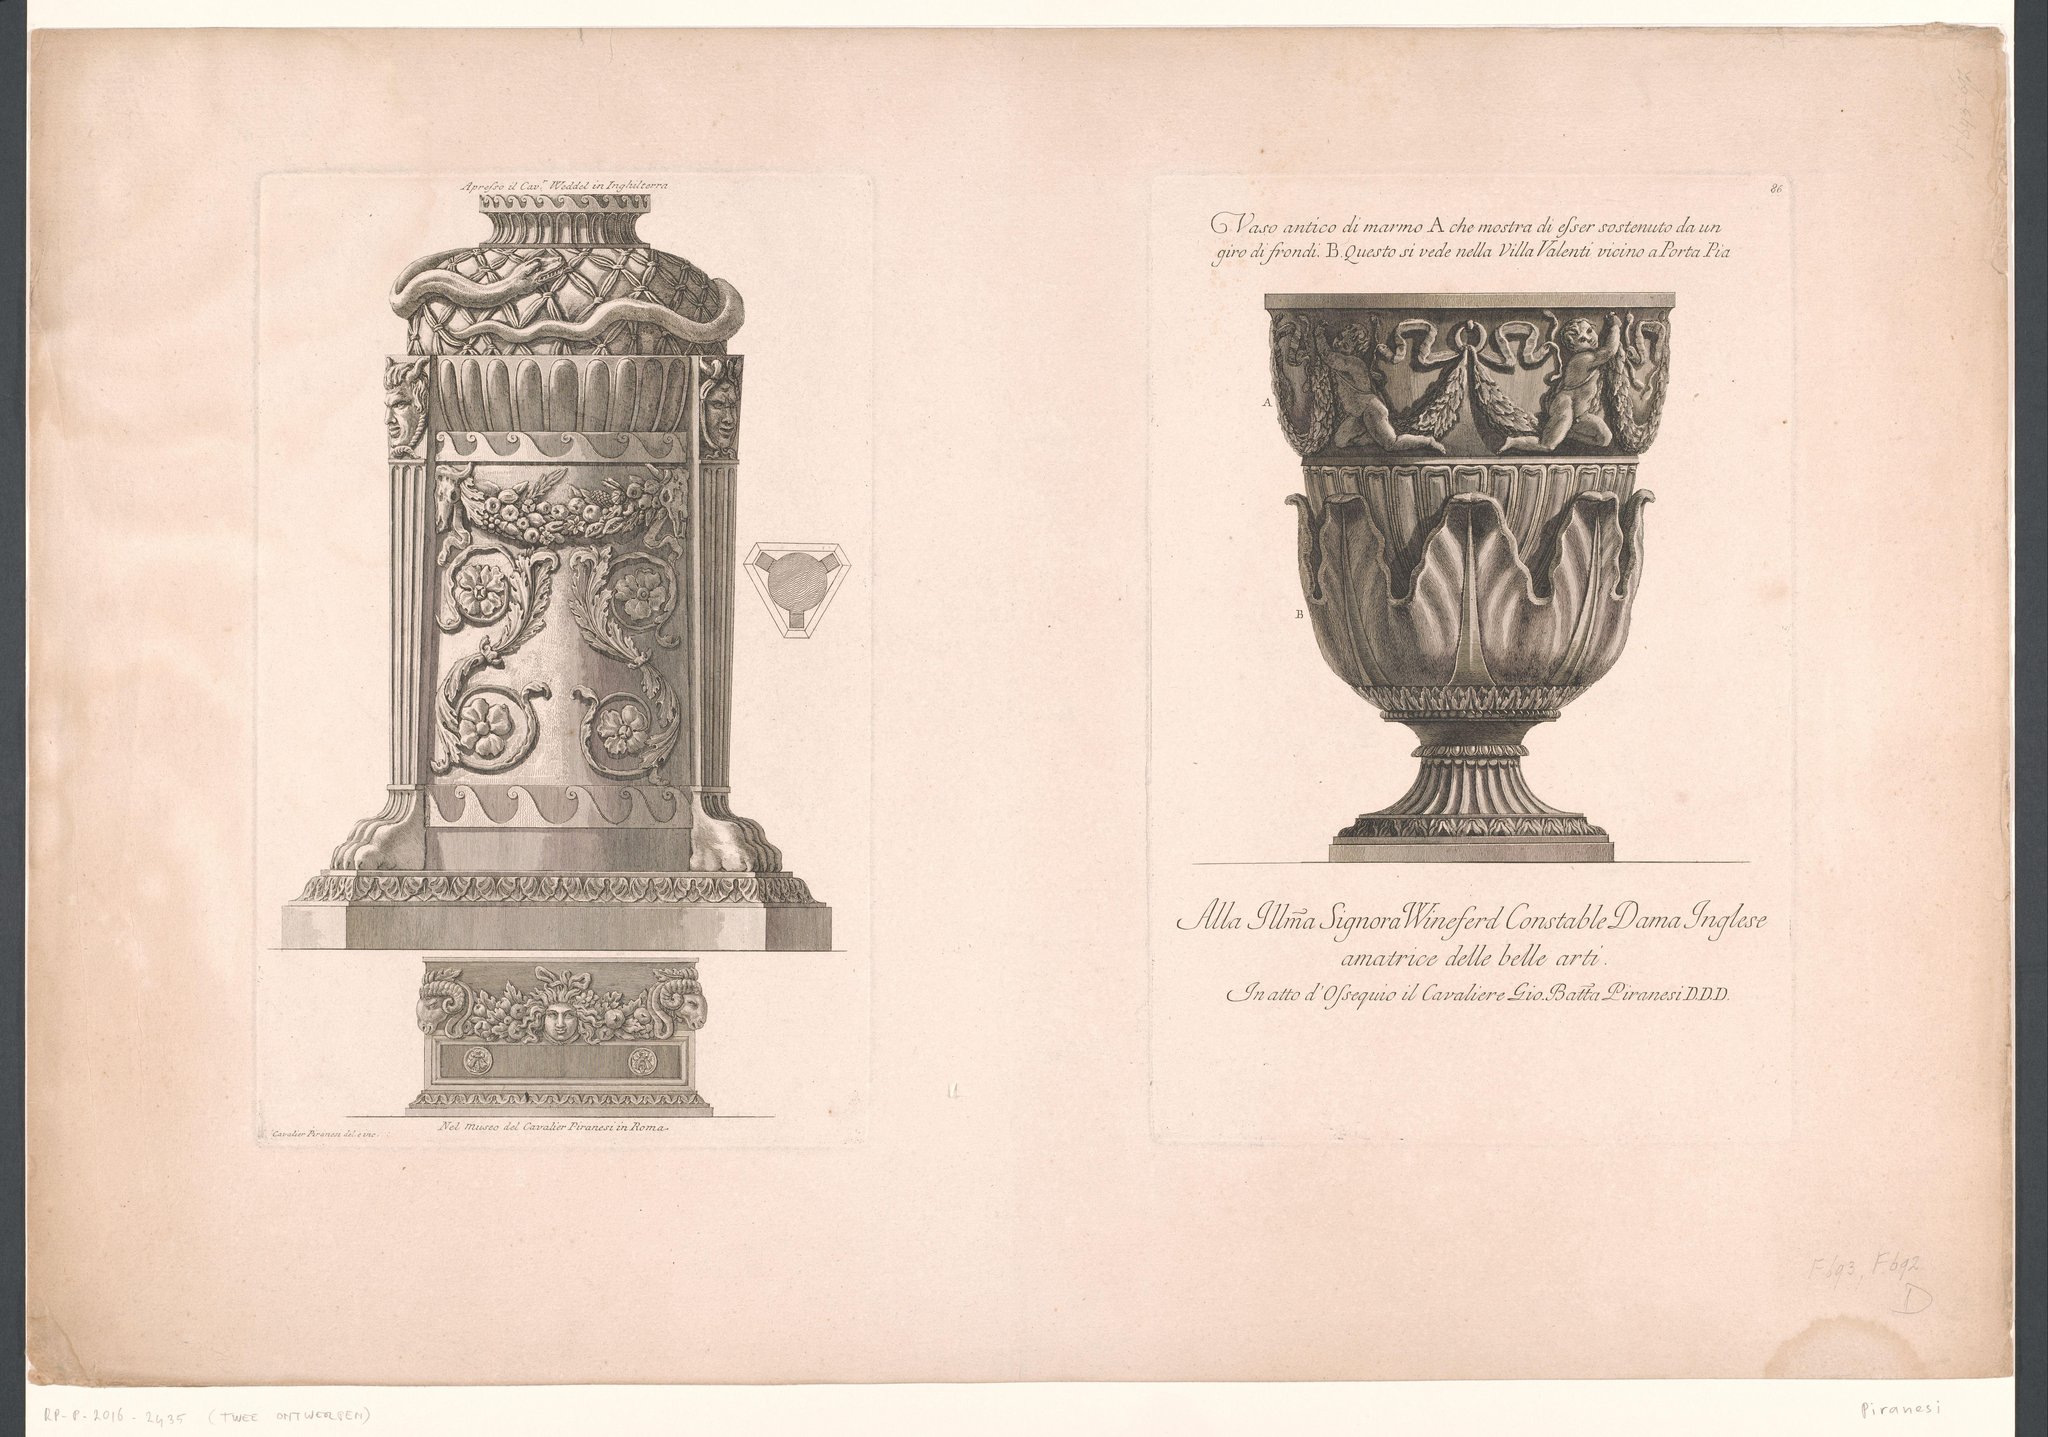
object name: print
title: Vasi, candelabri, cippi, sarcofagi, tripodi, lucerne, ed ornamenti antichi disegn. ed incisi dal cav. Gio. Batta Piranesi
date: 1778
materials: paper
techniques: etching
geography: rome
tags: tripod, vase ~ ornament, serpent ouroboros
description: Blad met twee voorstellingen van een antieke tripod en een vaas. Links: een antieke tripod met een ouroborus, maskers en een guirlande. Rechts een bovenaanzicht. Tekst boven en onder voorstelling. Rechts: een antieke vaas met putti en guirlandes. Tekst en verklarende letters boven voorstelling. Opdracht in ondermarge.